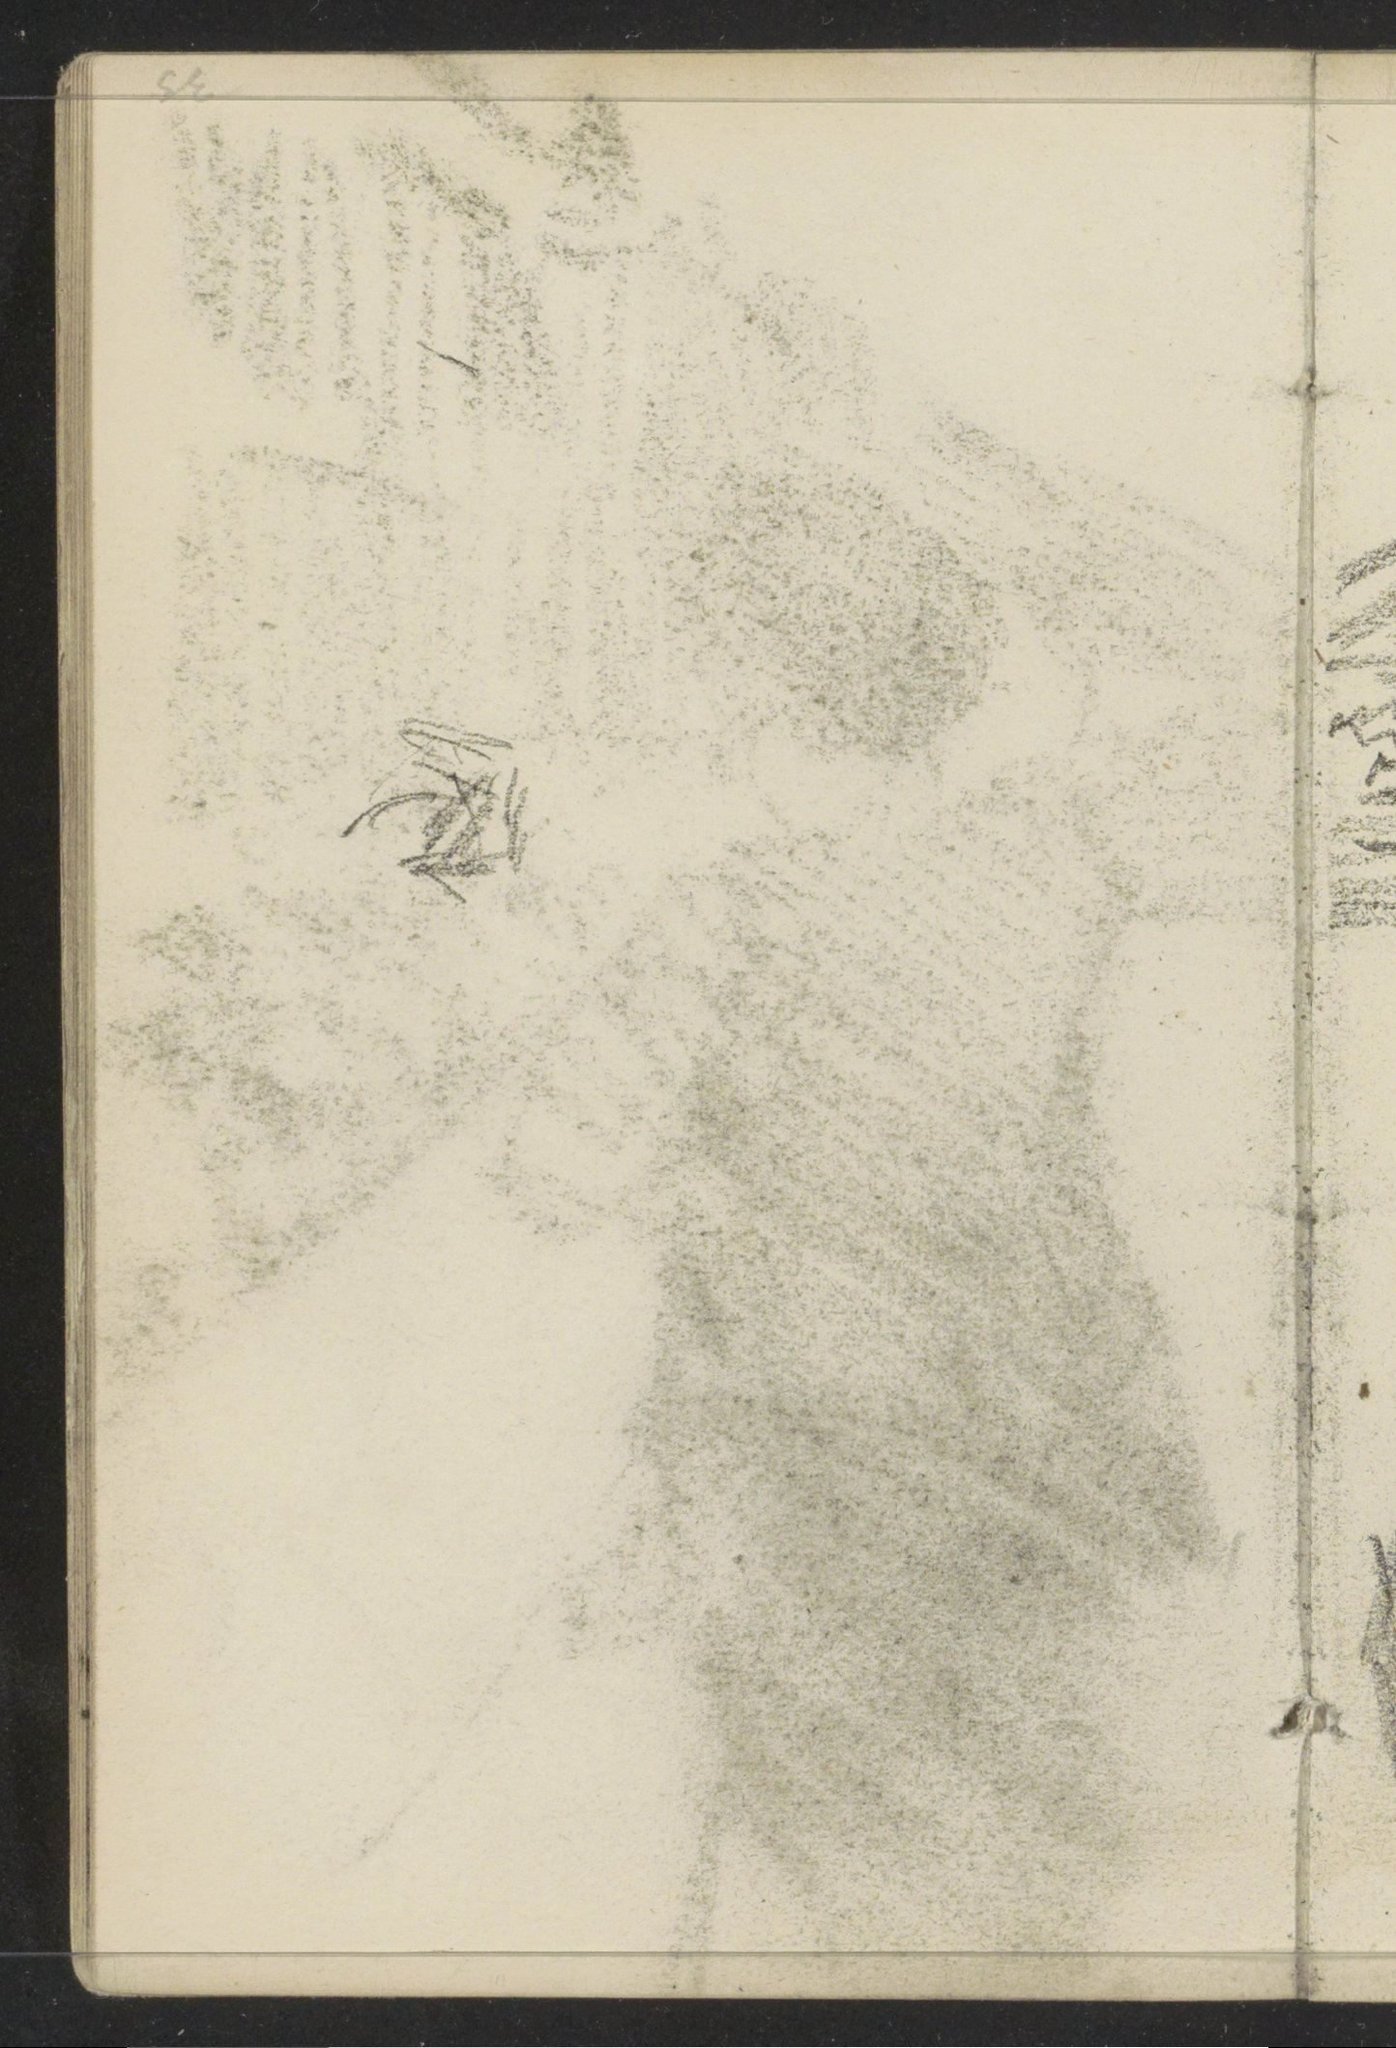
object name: sketchbook leaf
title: Studie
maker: isaac israels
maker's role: draughtsman, painter, print maker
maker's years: 1865-1934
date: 1887-1934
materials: chalk, paper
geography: paris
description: Blad 8 verso uit schetsboek LIX met 21 bladen.